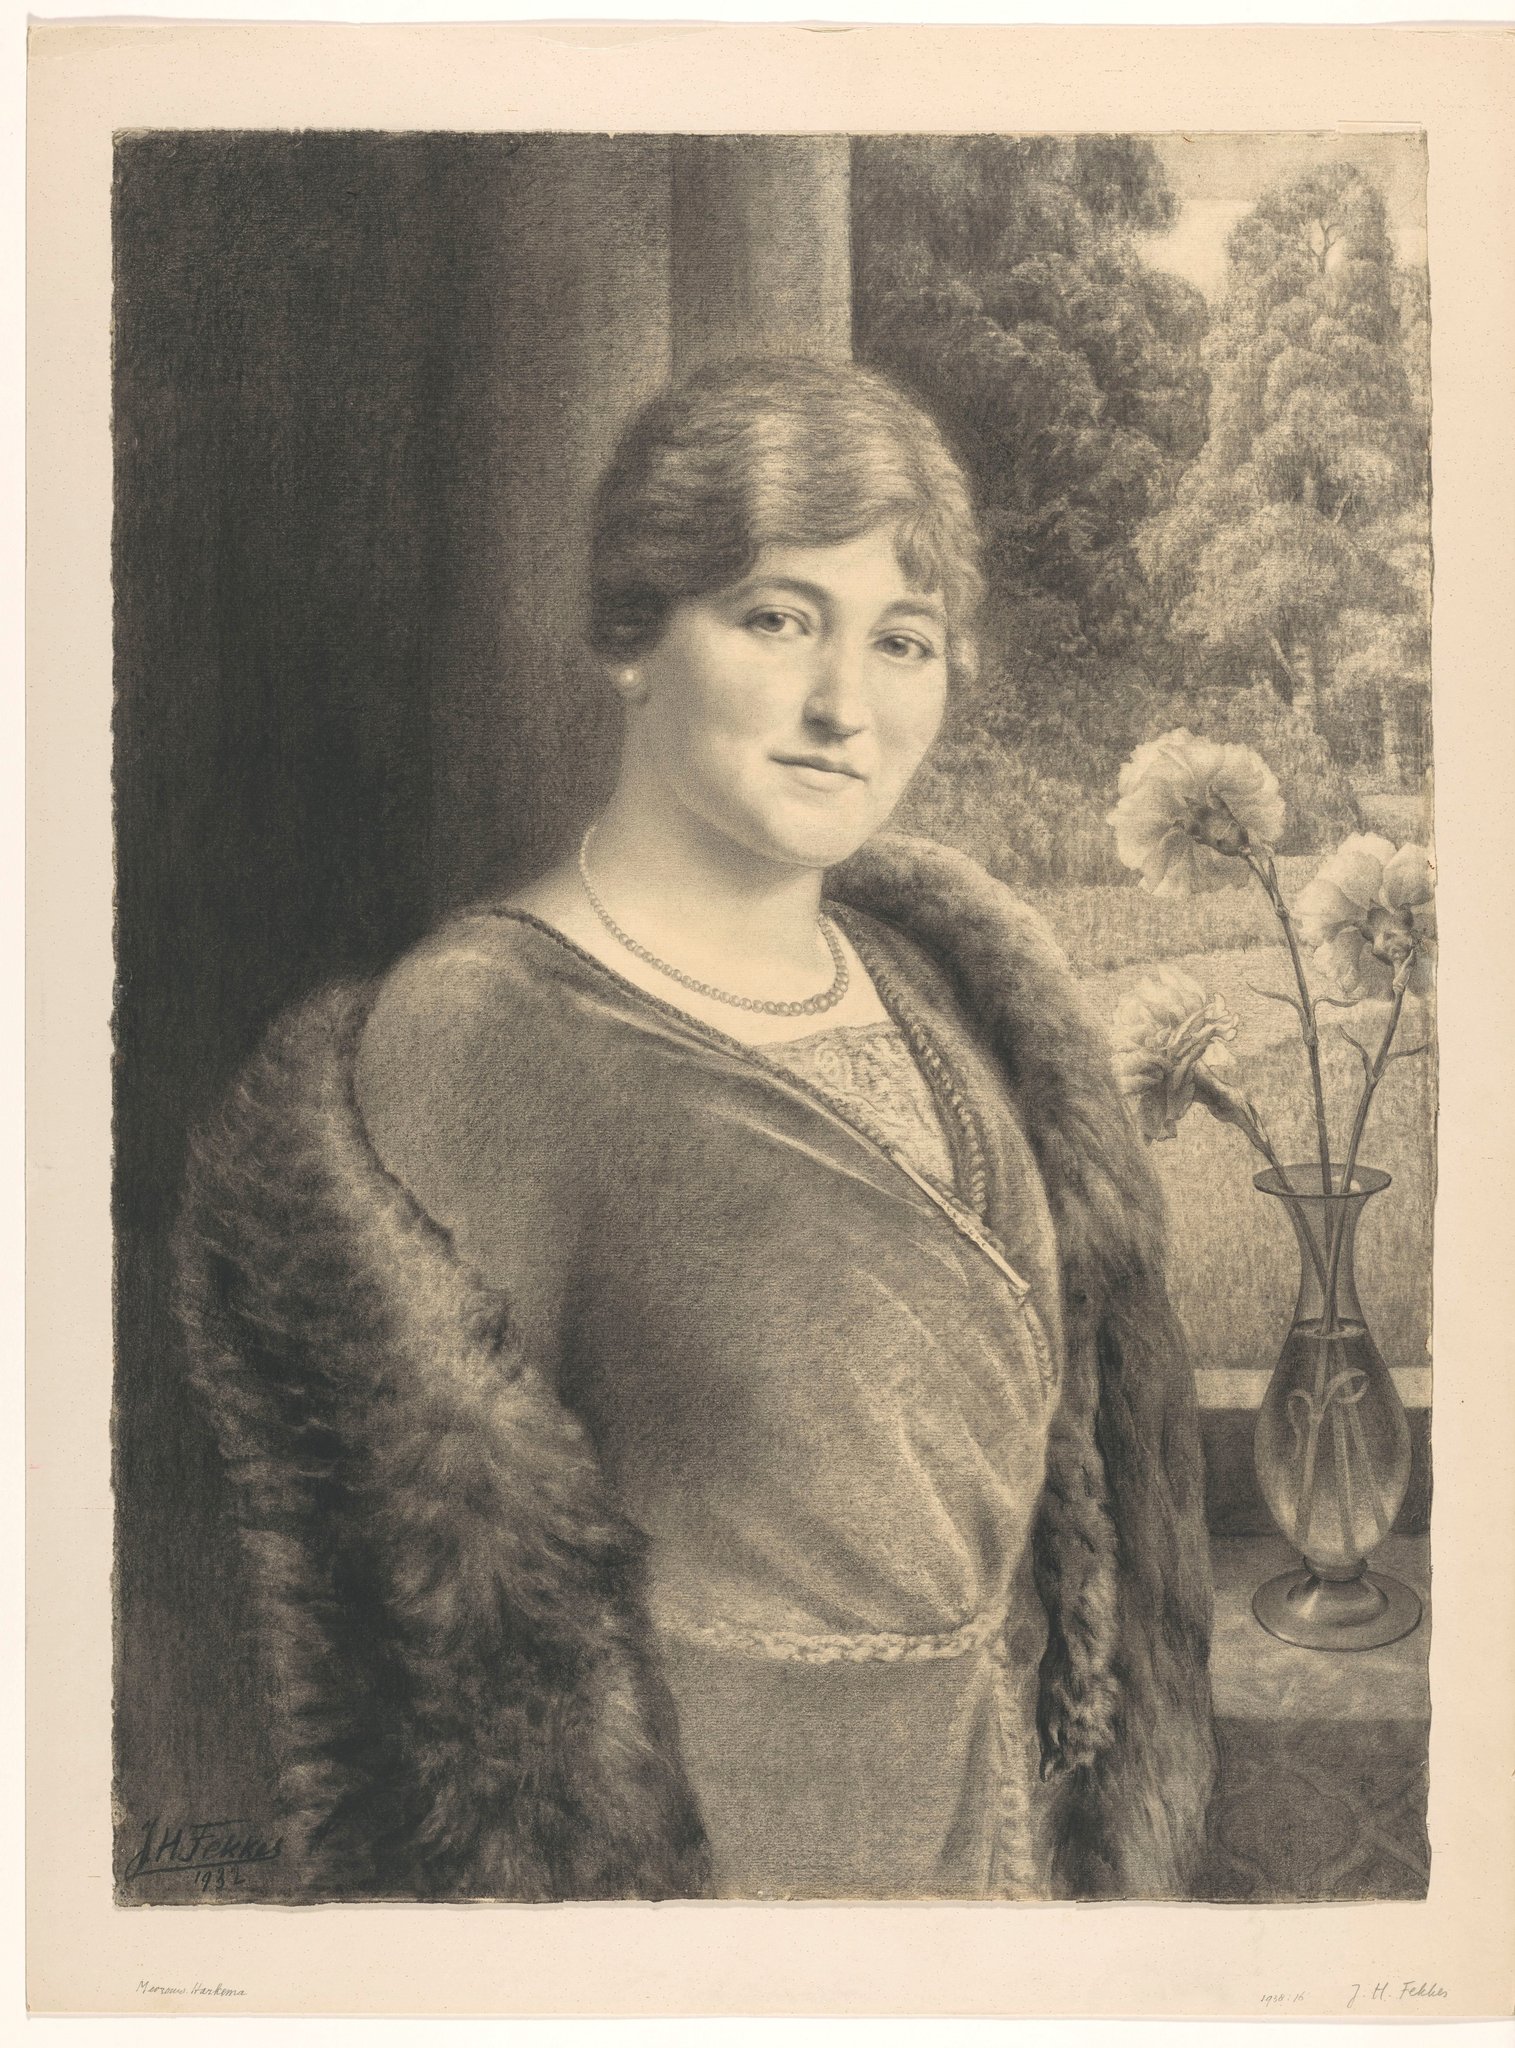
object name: drawing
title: Portret van een onbekende vrouw voor een raam, mogelijk Eiske Harkema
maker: jan fekkes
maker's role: draughtsman, print maker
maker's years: 1885-1933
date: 1932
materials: chalk, paper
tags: female sex; woman, historical persons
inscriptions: date